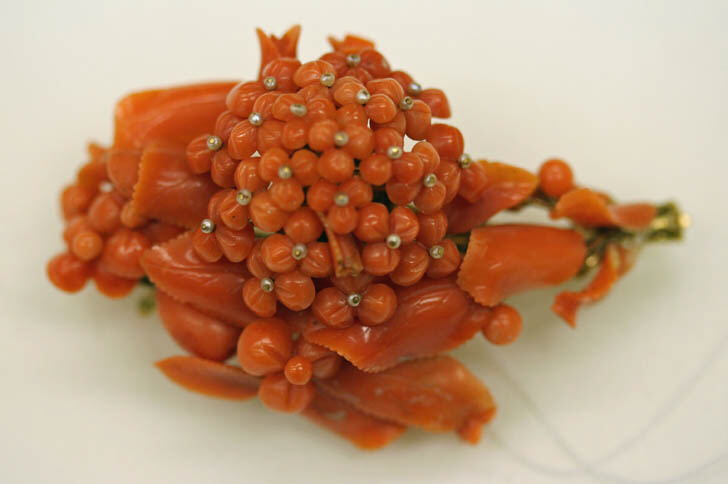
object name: jewelry set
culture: american or european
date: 1850-1899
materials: coral, gold